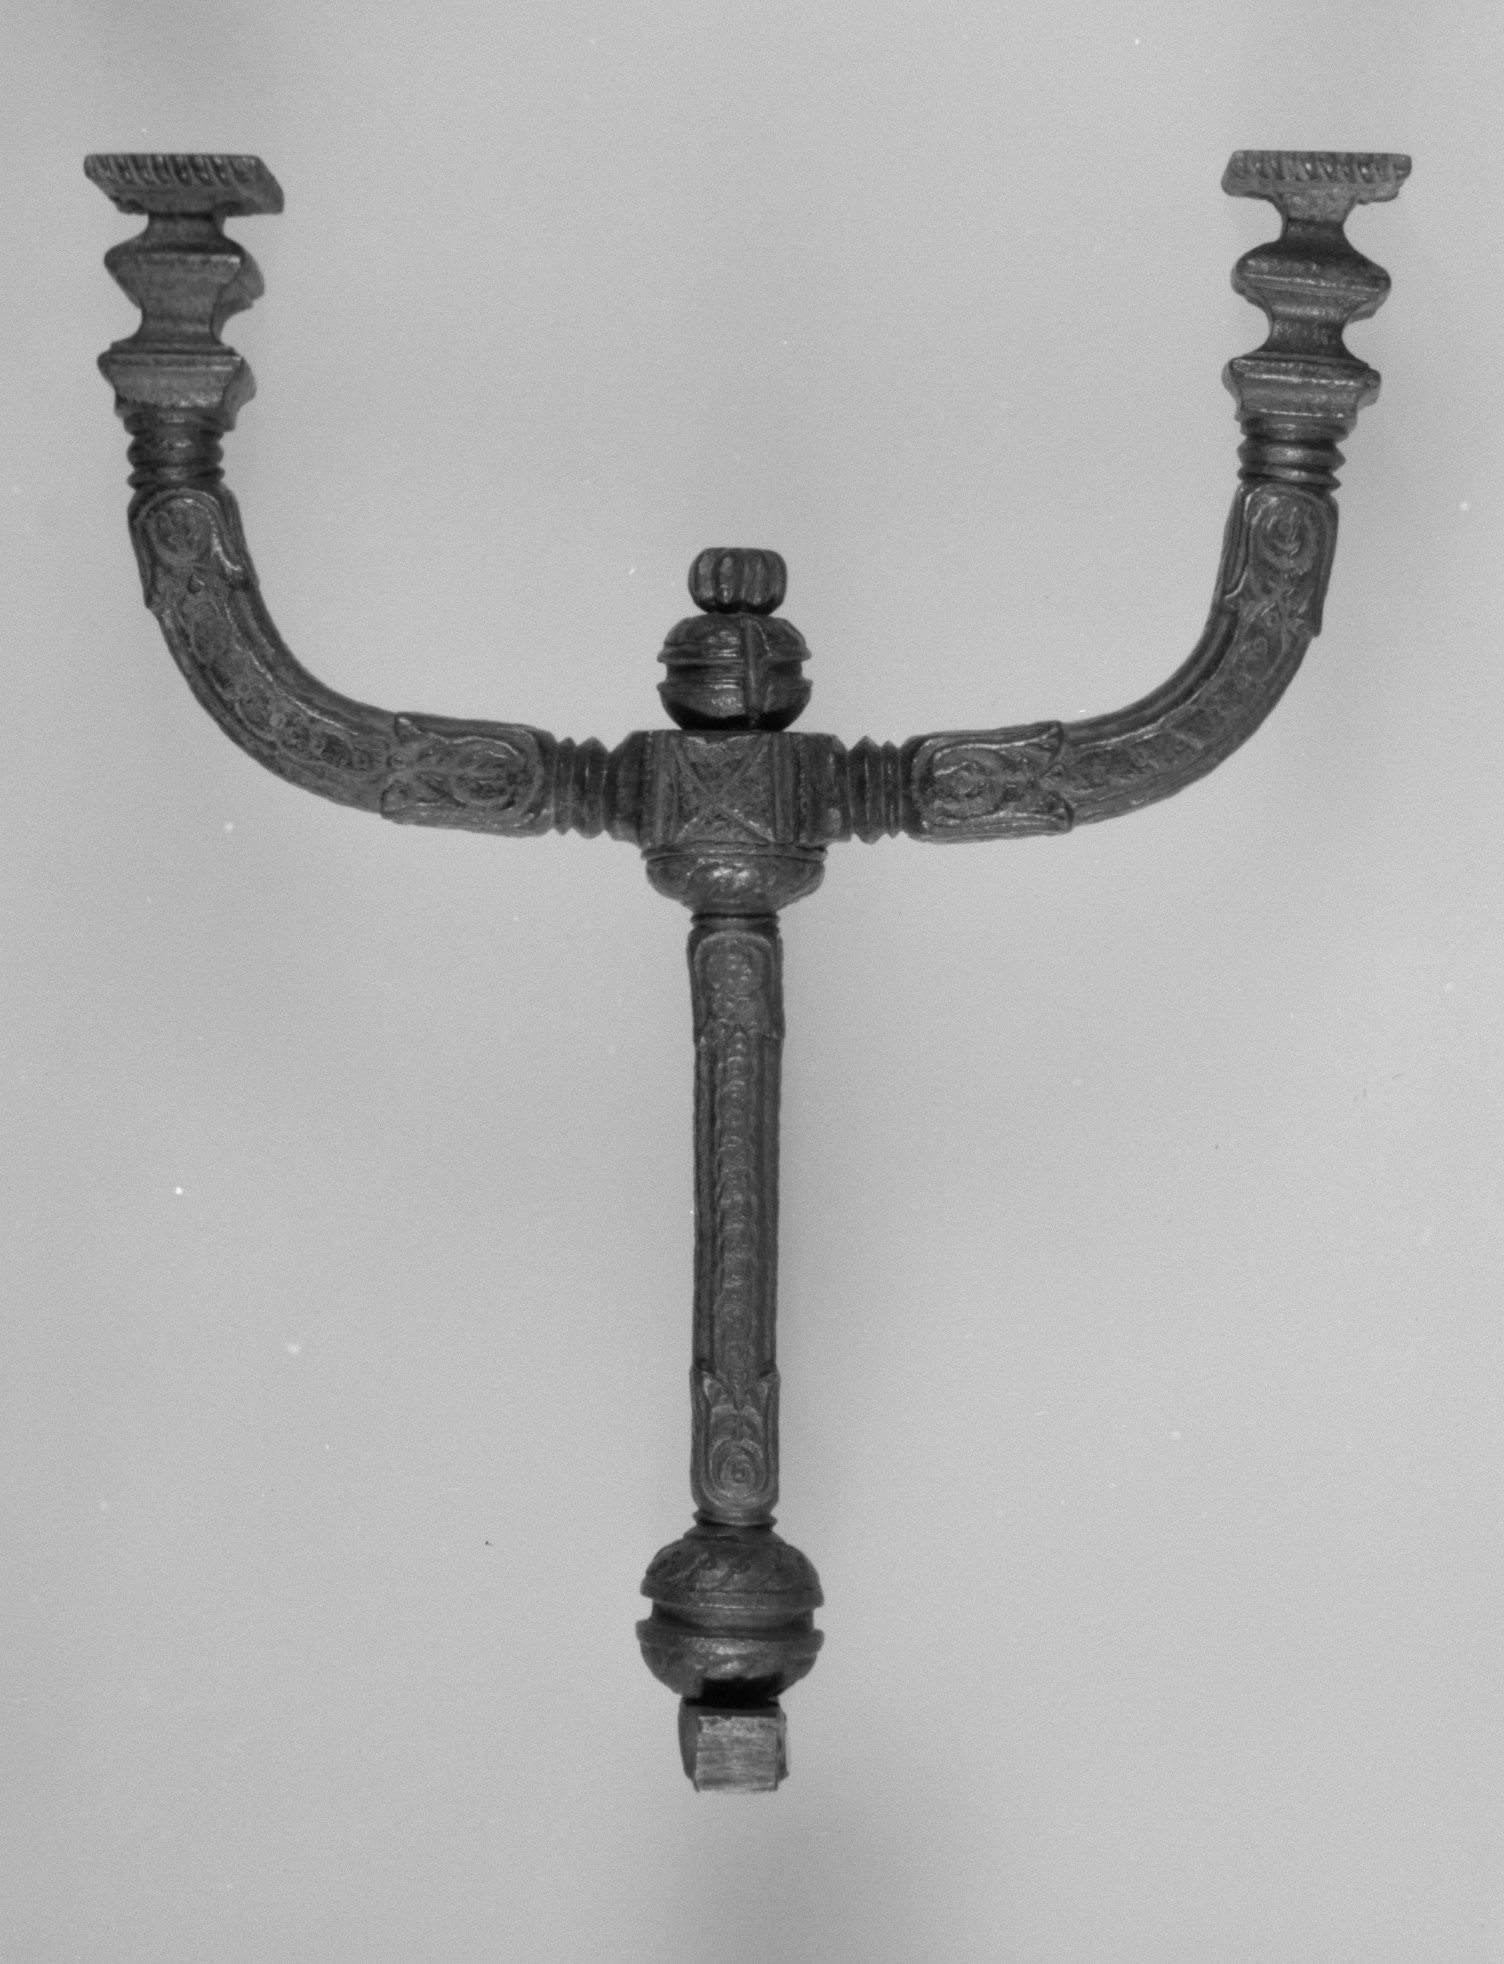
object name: bed leg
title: Bed leg (one of four)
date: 1501-1600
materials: iron